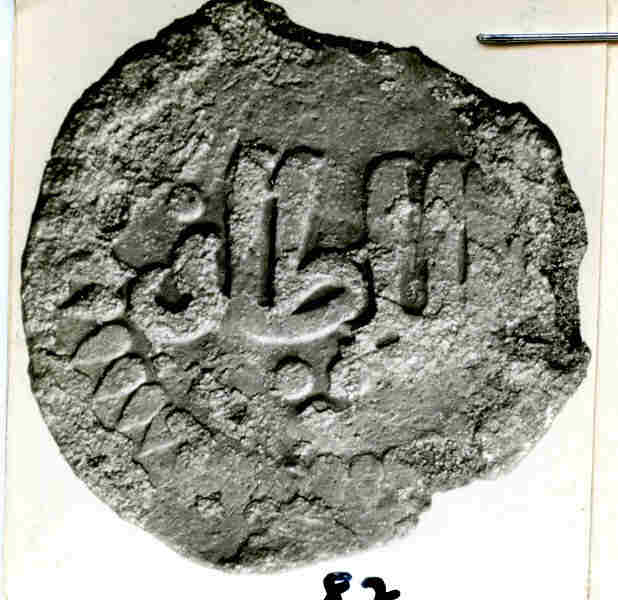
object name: coin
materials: copper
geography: iran